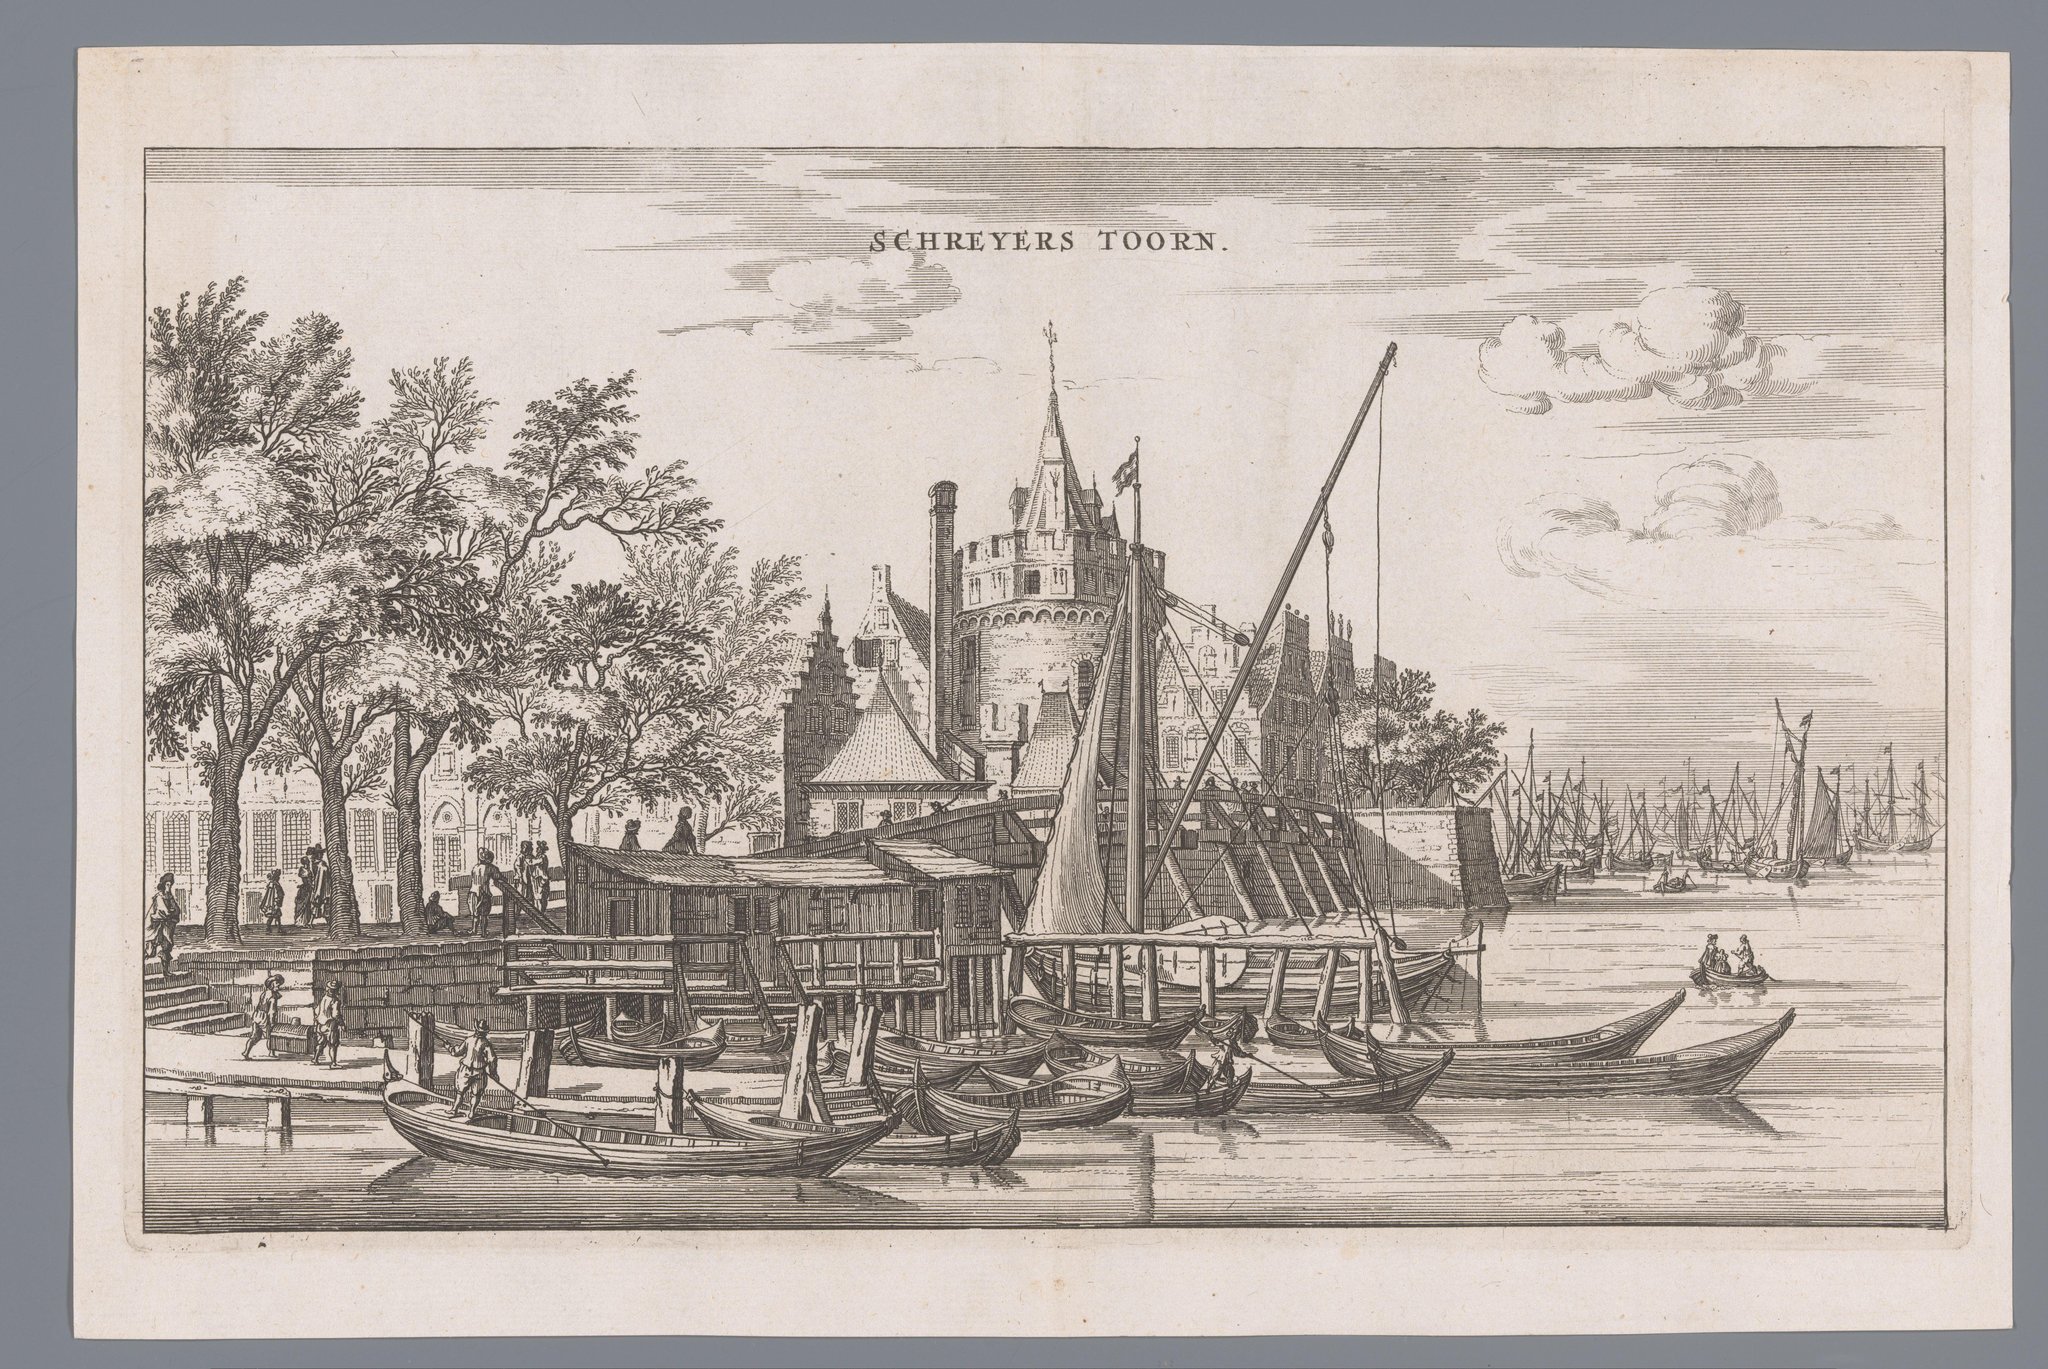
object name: print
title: Gezicht op de Schreierstoren te Amsterdam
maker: jacob van meurs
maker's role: draughtsman, print maker, publisher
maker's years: 1619-1680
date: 1663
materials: paper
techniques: engraving, etching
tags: sailing-ship, sailing-boat, towers ~ fortified city, rowing-boat, canoe, etc., canals, waters (in city), pier, quay, wharf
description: Deze prent komt voor in: Dapper, Olfert. Historische beschryving der stadt Amsterdam (...). Amsterdam: Jacob van Meurs, 1663, p. 448-449. En in: Zesen, Philipp von. Beschreibung der Stadt Amsterdam (...). Amsterdam: Joachim Nosche, 1664, p. 100-101. In sommige exemplaren van Olfert Dapper komt een iets gewijzigde staat voor, met een Franse titel boven het Nederlandse opschrift.